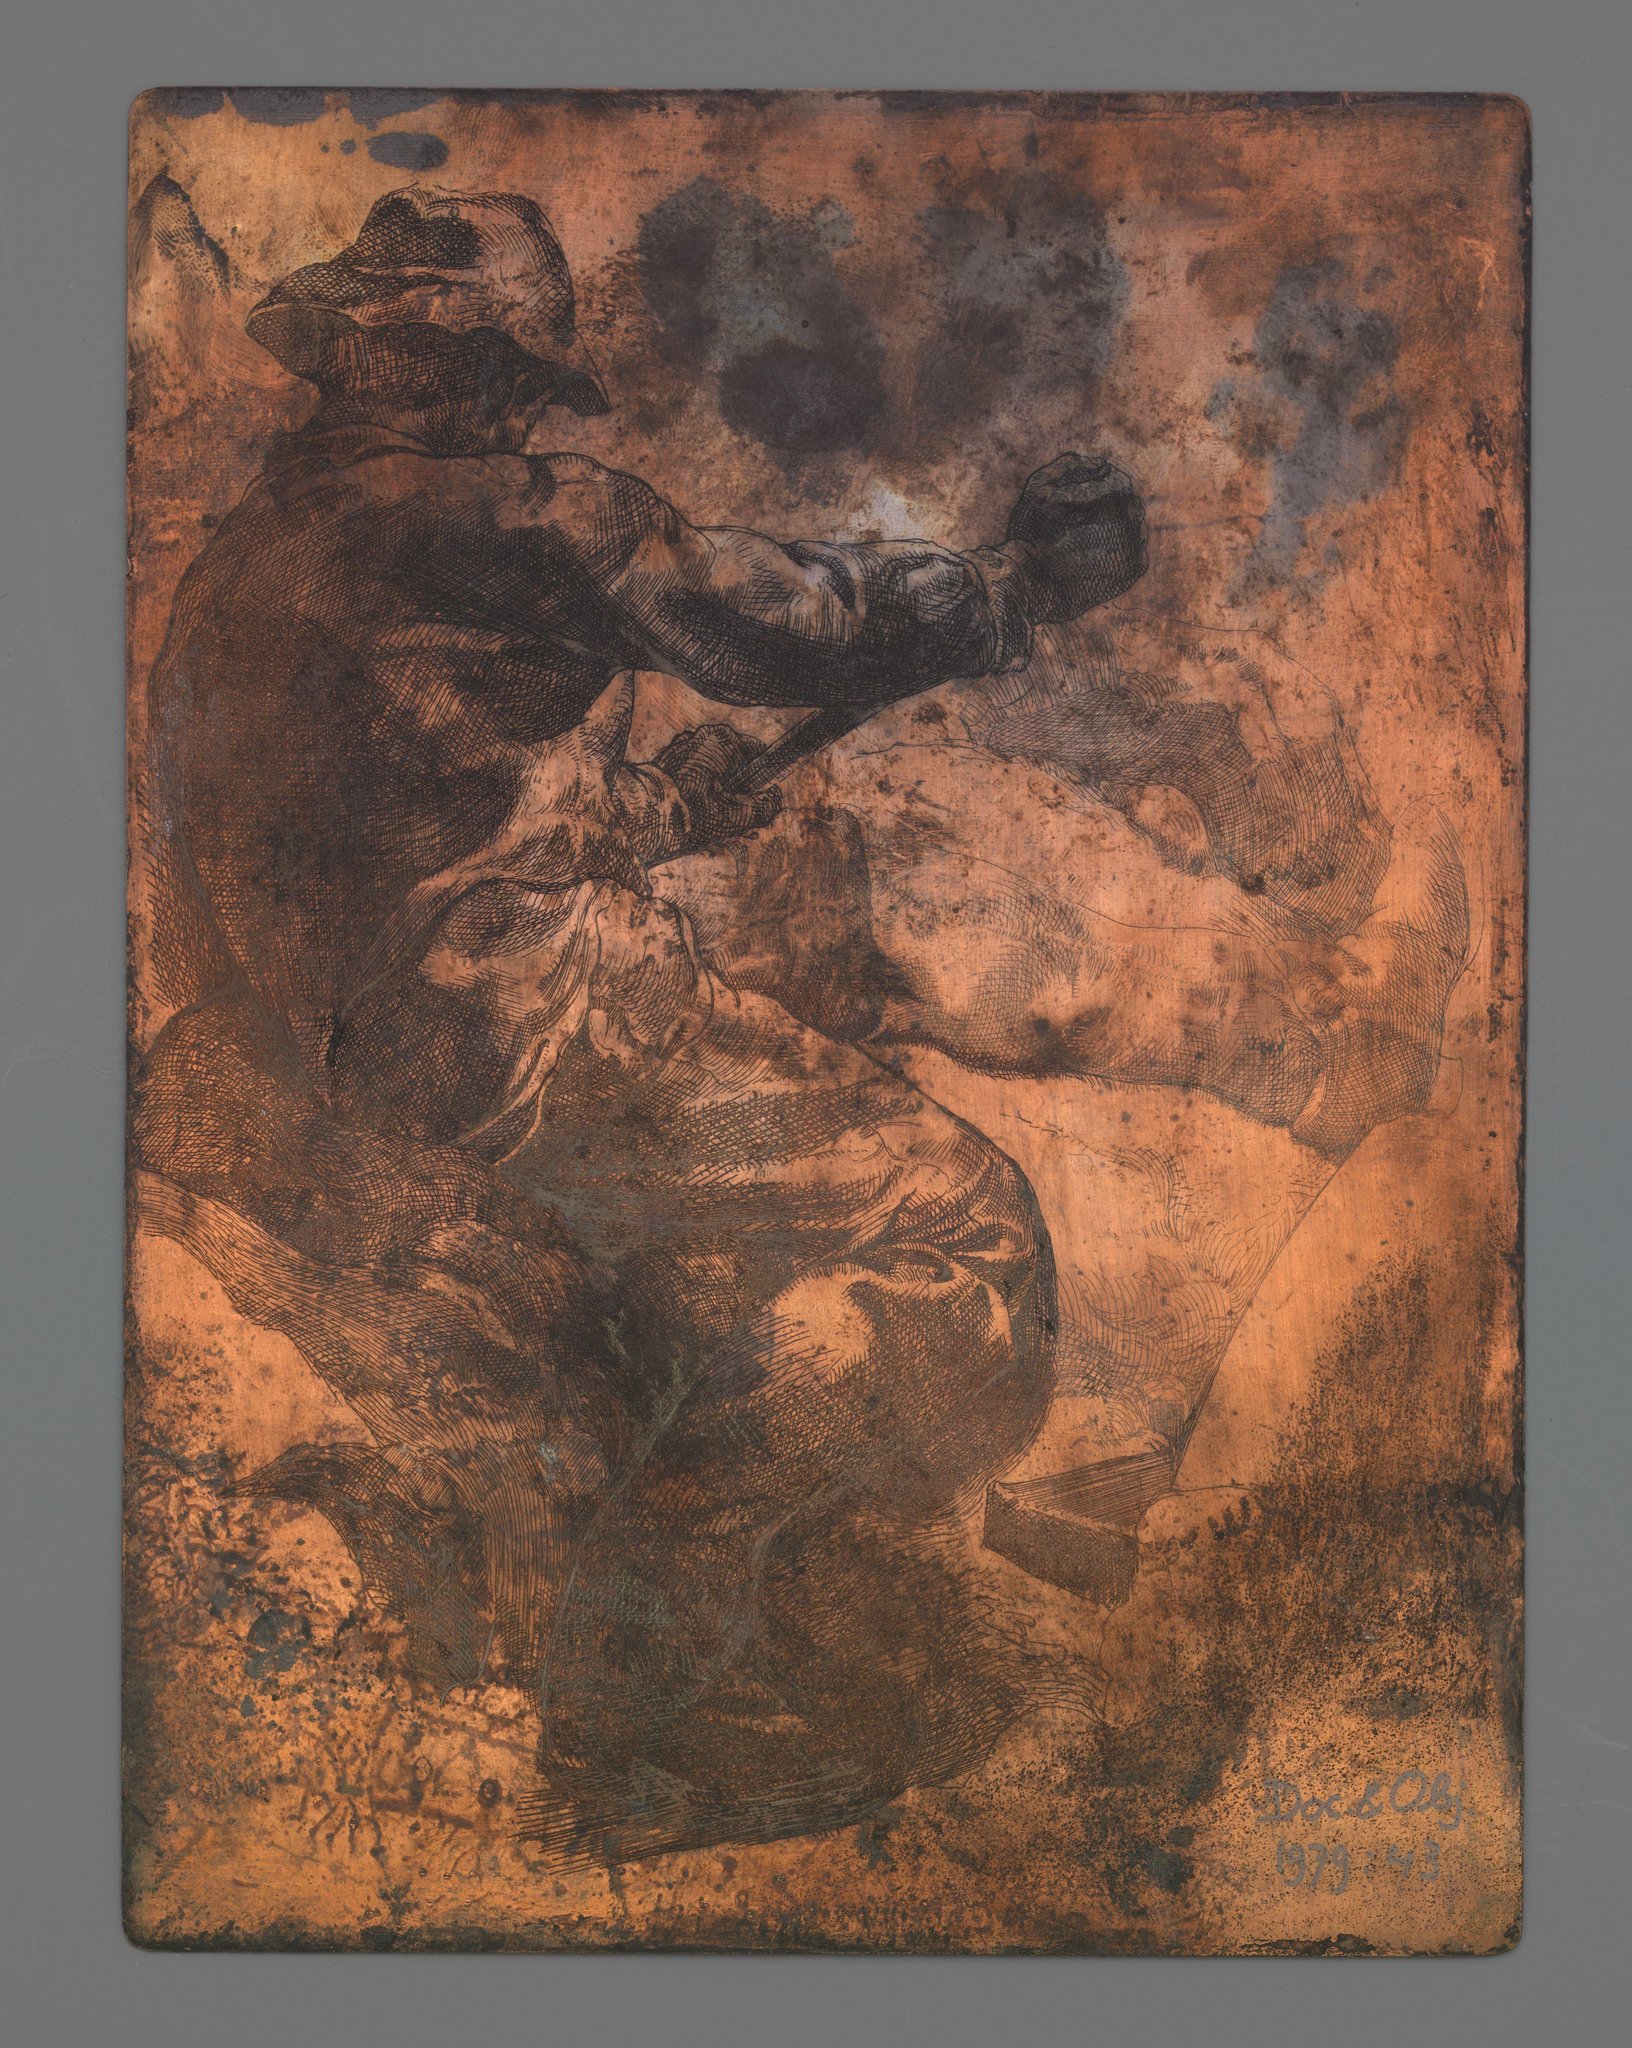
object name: copper plate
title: Arbeider op de rug gezien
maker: johannes josephus aarts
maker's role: draughtsman, print maker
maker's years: 1871-1934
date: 1881-1934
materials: copper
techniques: etching